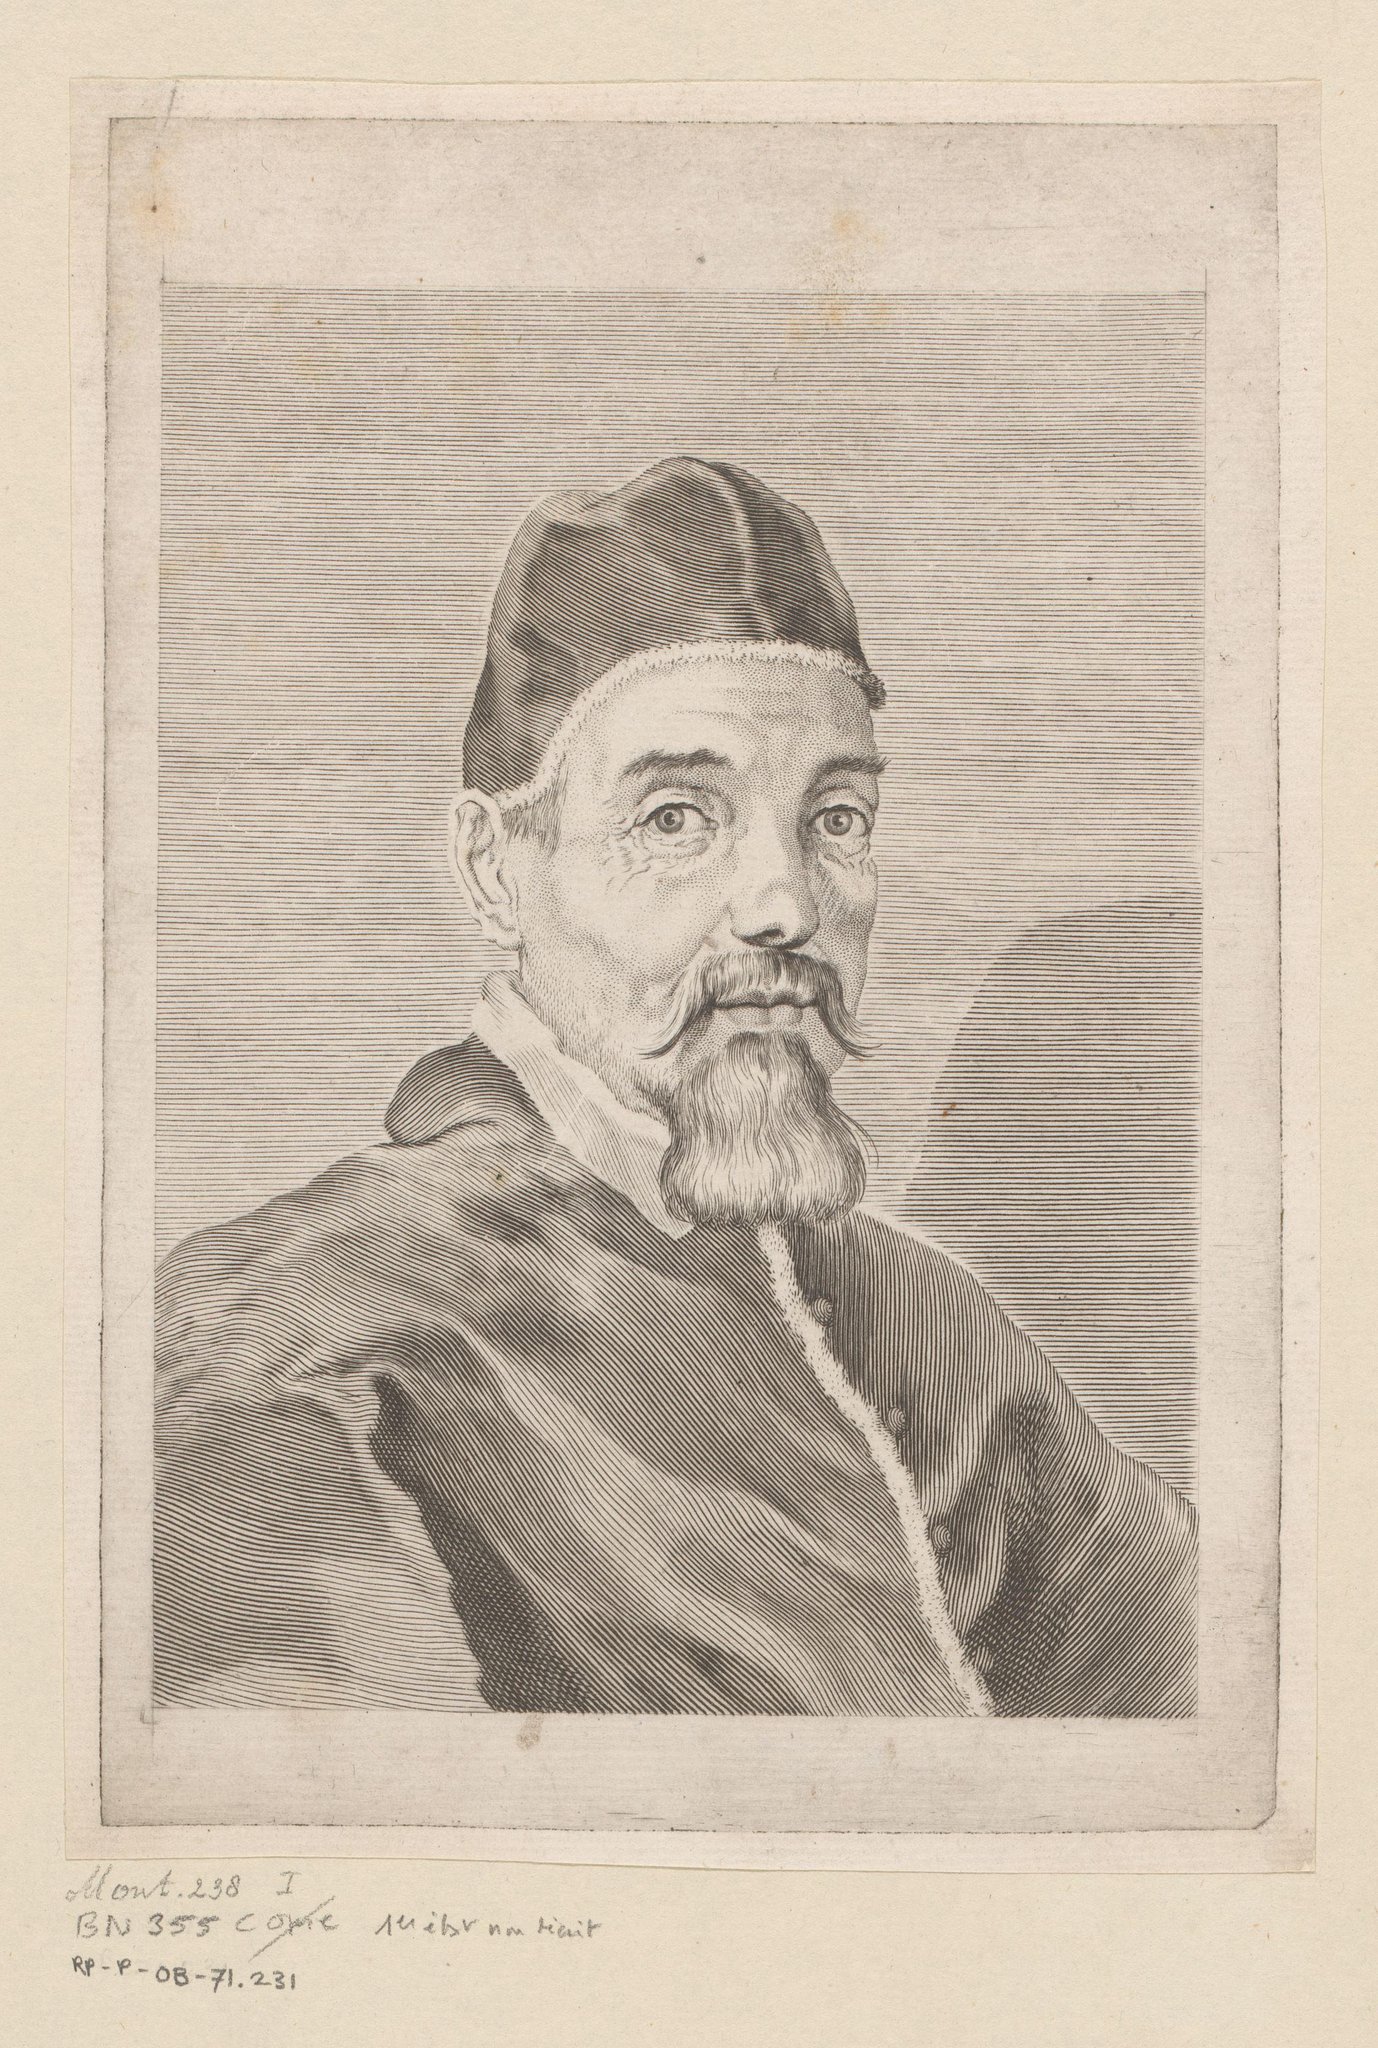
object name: print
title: Portret van Urbanus VIII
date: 1631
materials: paper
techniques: engraving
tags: rome, clergyman, urbanus viii, historical persons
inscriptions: collector's mark: Lugt 240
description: Prent uit: Urbanus VIII. Maphaei S.R.E Cardinalis Barberini Nunc Urbani P.P. VIII Poemata. Rome: s.n., 1631.